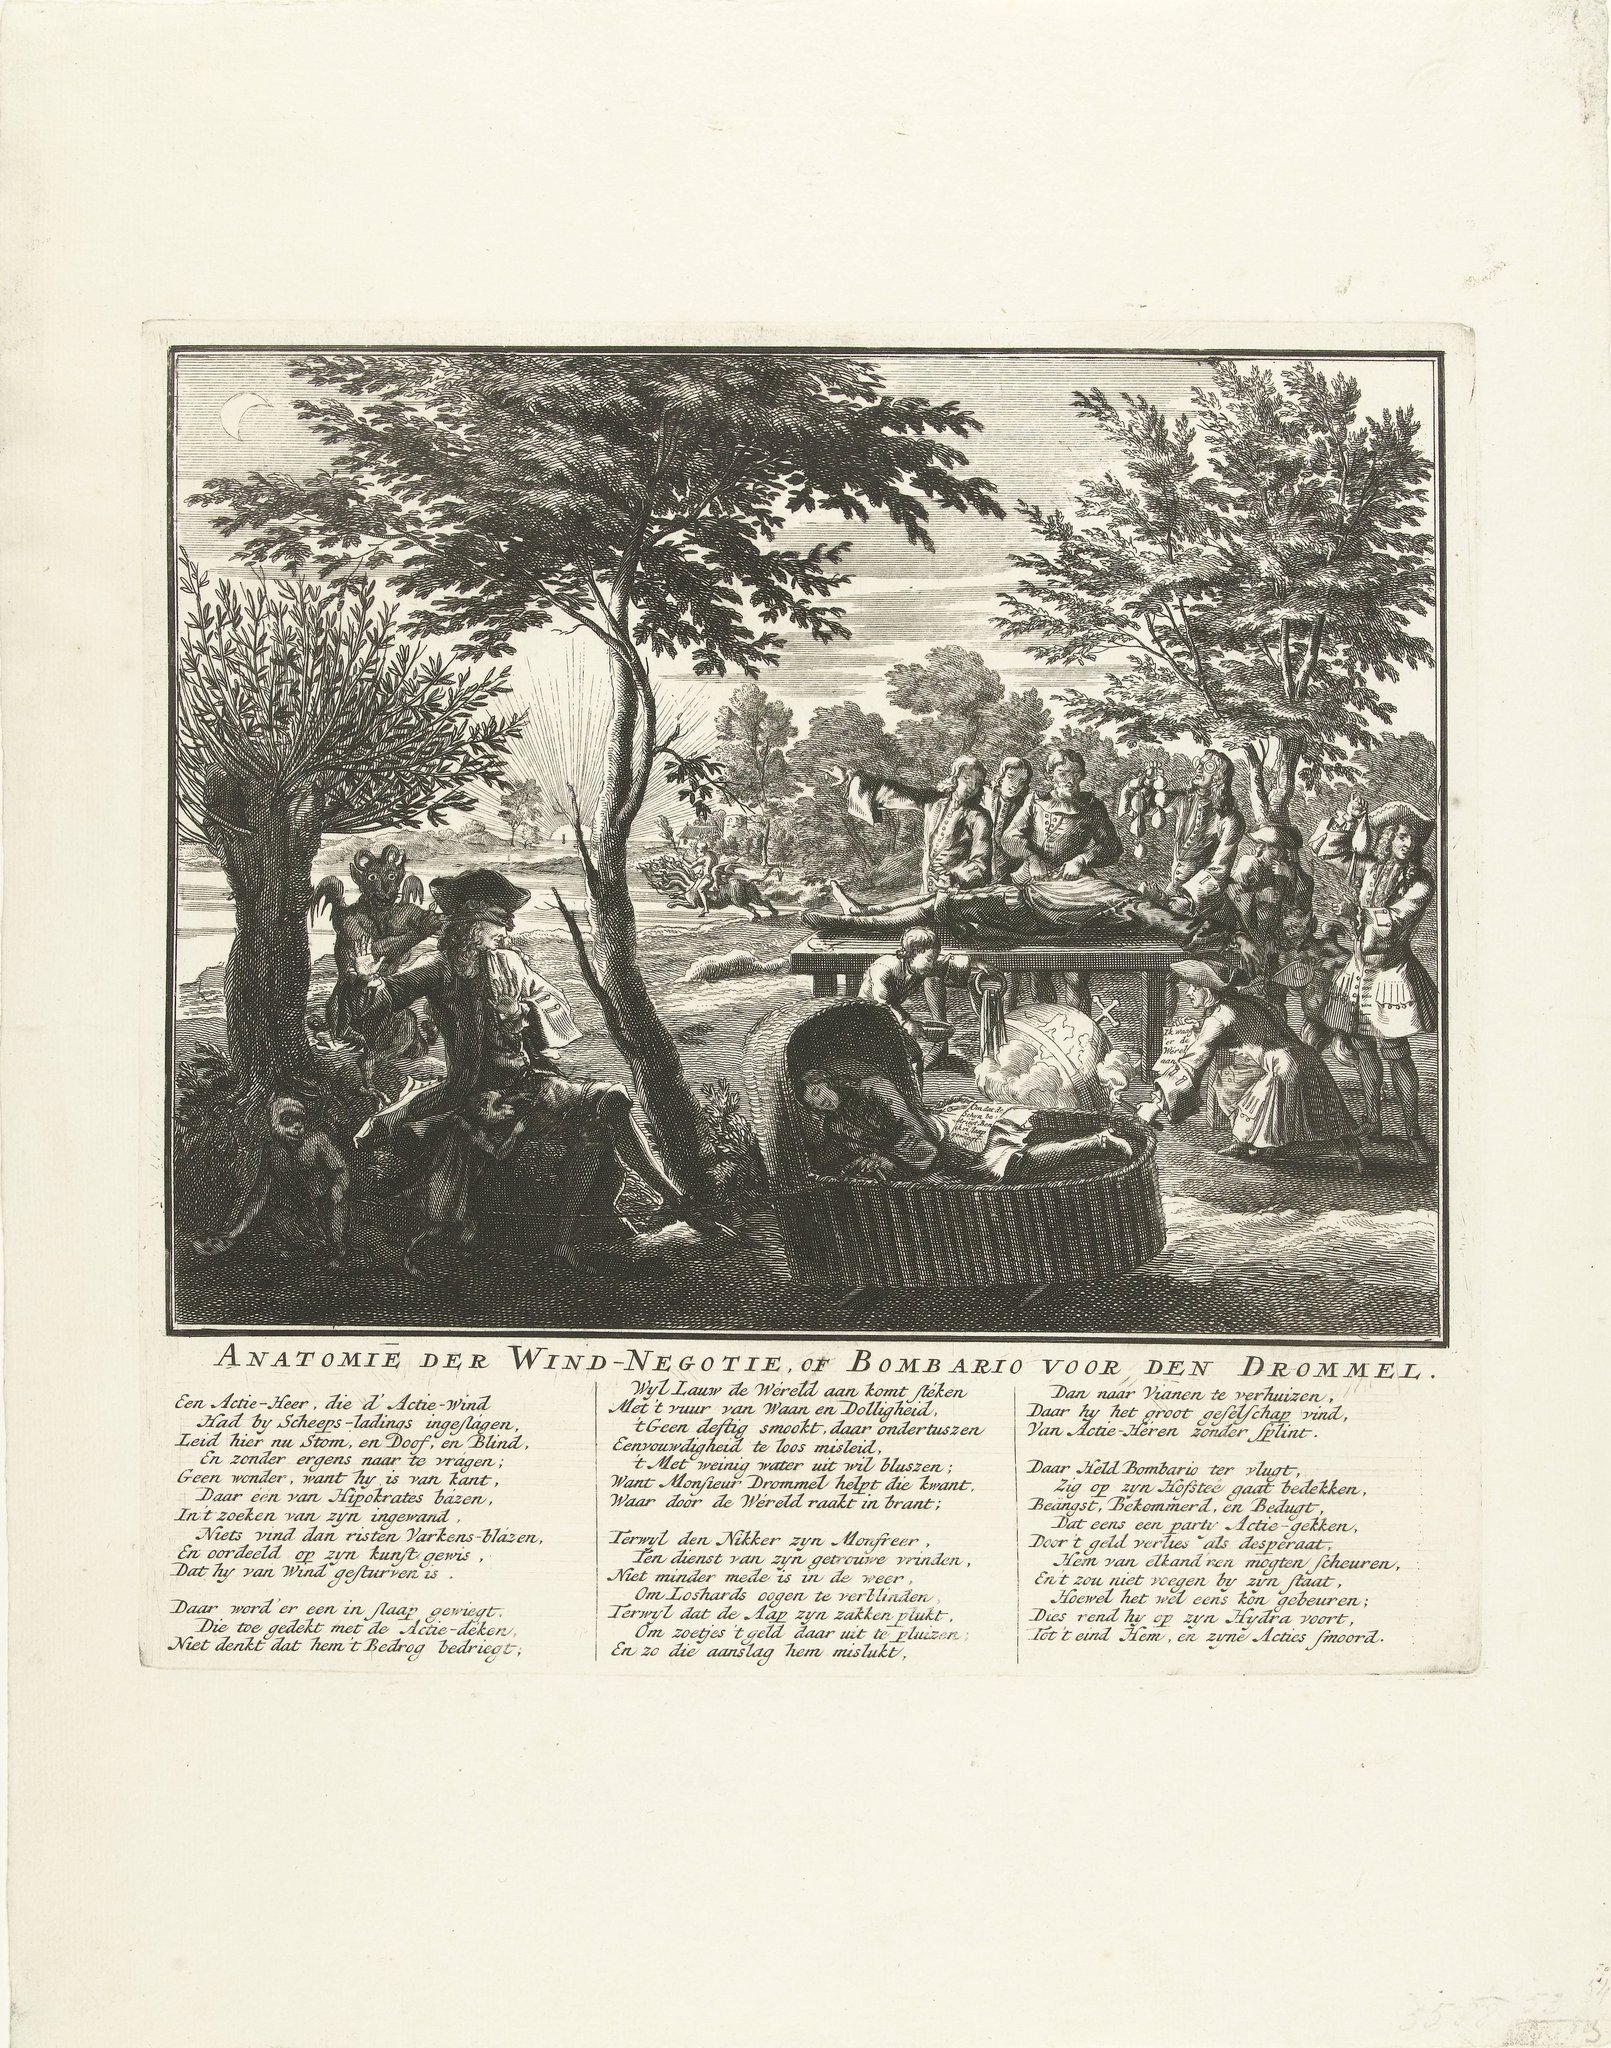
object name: cartoon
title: Het Groote Tafereel der Dwaasheid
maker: Anonymous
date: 1720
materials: paper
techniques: engraving, etching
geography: northern netherlands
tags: dissection, negative results and undesired aspects of trading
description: Anatomie van de Windhandel van 1720. Een actiehandelaar die aan wind gestorven is wordt op een tafel ontleed. Op de voorgrond wordt een man geblinddoekt door een duivel en beroofd door apen, een andere man ligt slapend in een wieg. Met onderschrift van vier verzen in het Nederlands. Prent 53 in de serie Het Groote Tafereel der Dwaasheid met spotprenten op de Windhandel of Actiehandel van 1720.